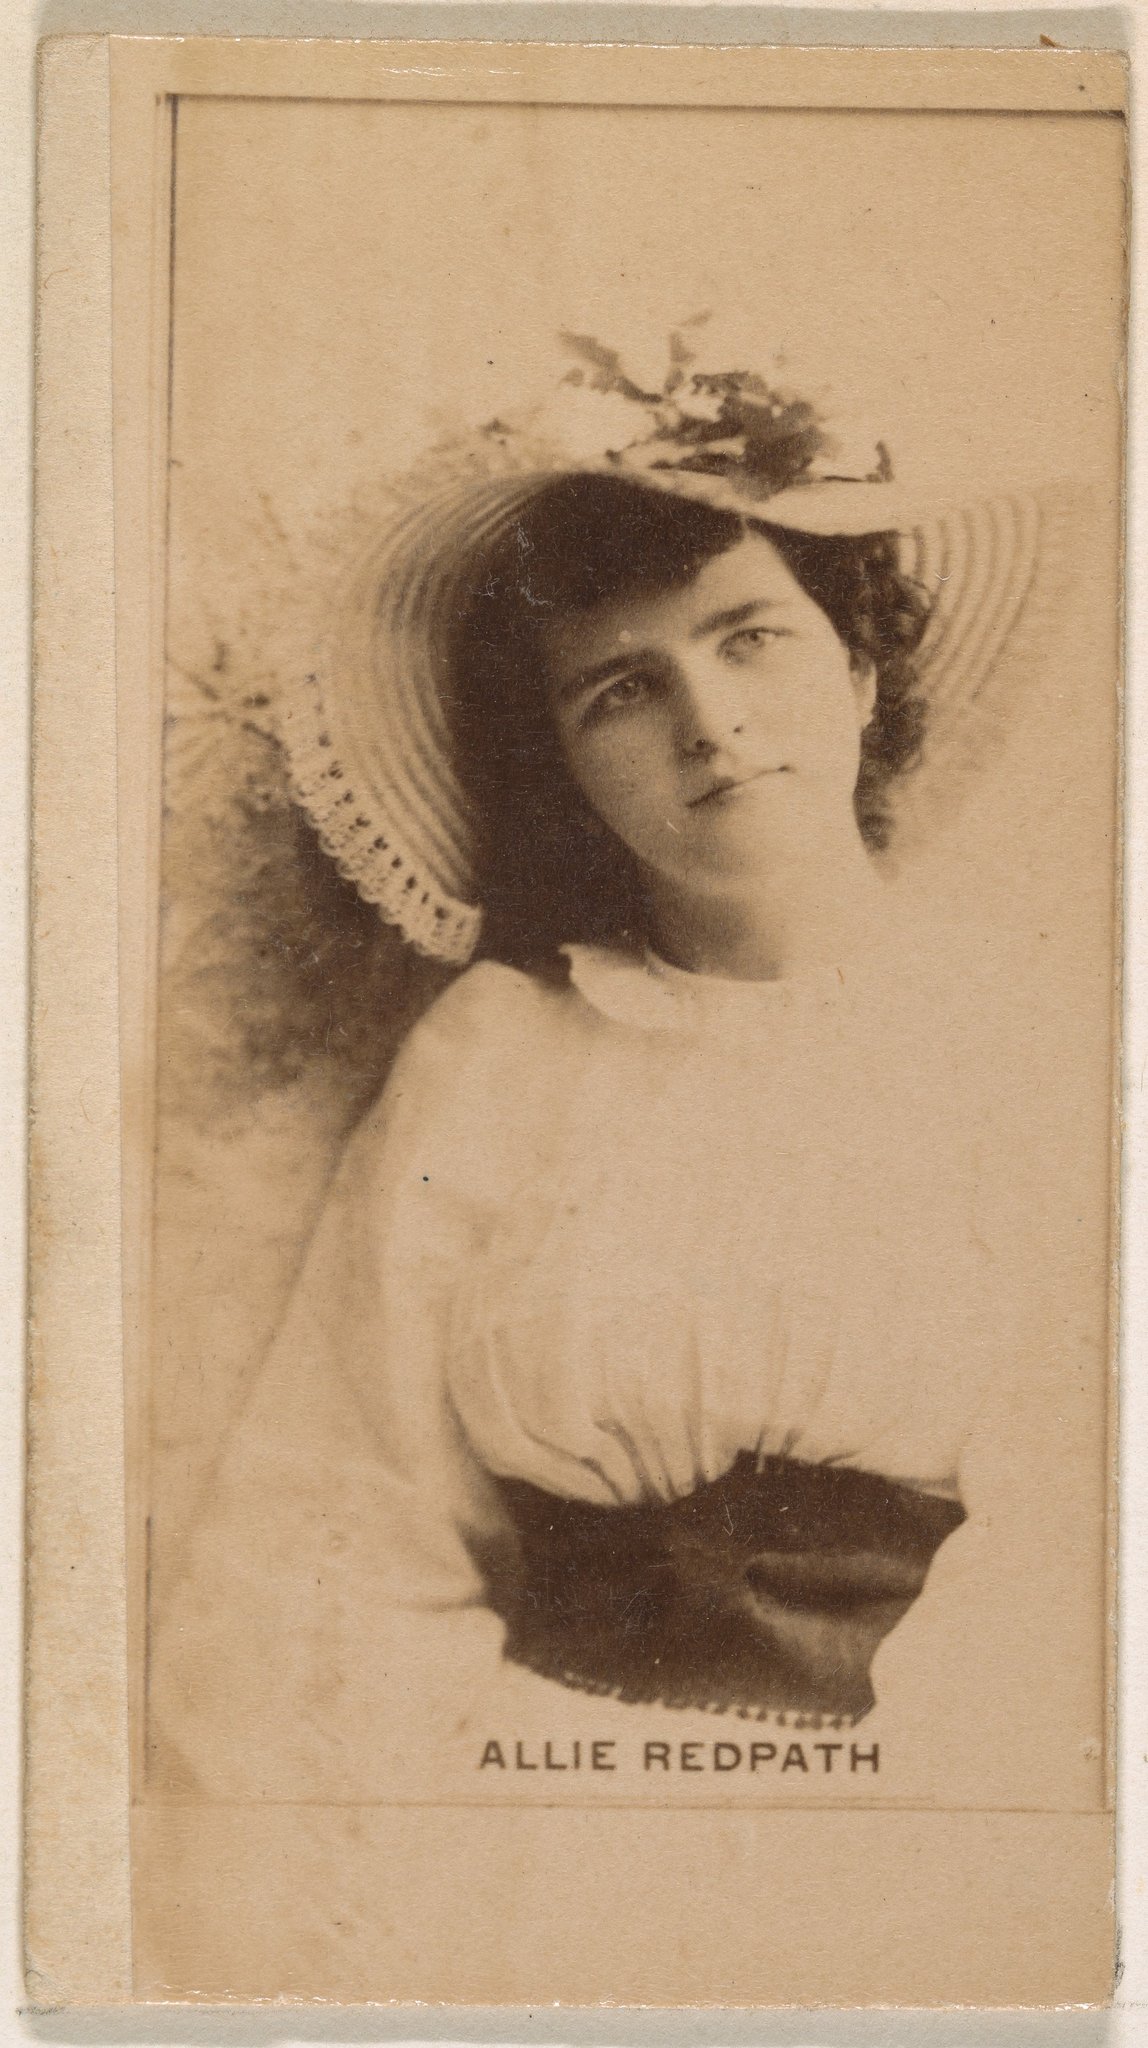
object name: photograph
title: Allie Redpath, from the Actresses series (N245) issued by Kinney Brothers to promote Sweet Caporal Cigarettes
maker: kinney brothers tobacco company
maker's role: publisher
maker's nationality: american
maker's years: 1869-2011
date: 1890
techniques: albumen silver print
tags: portraits,women,actresses